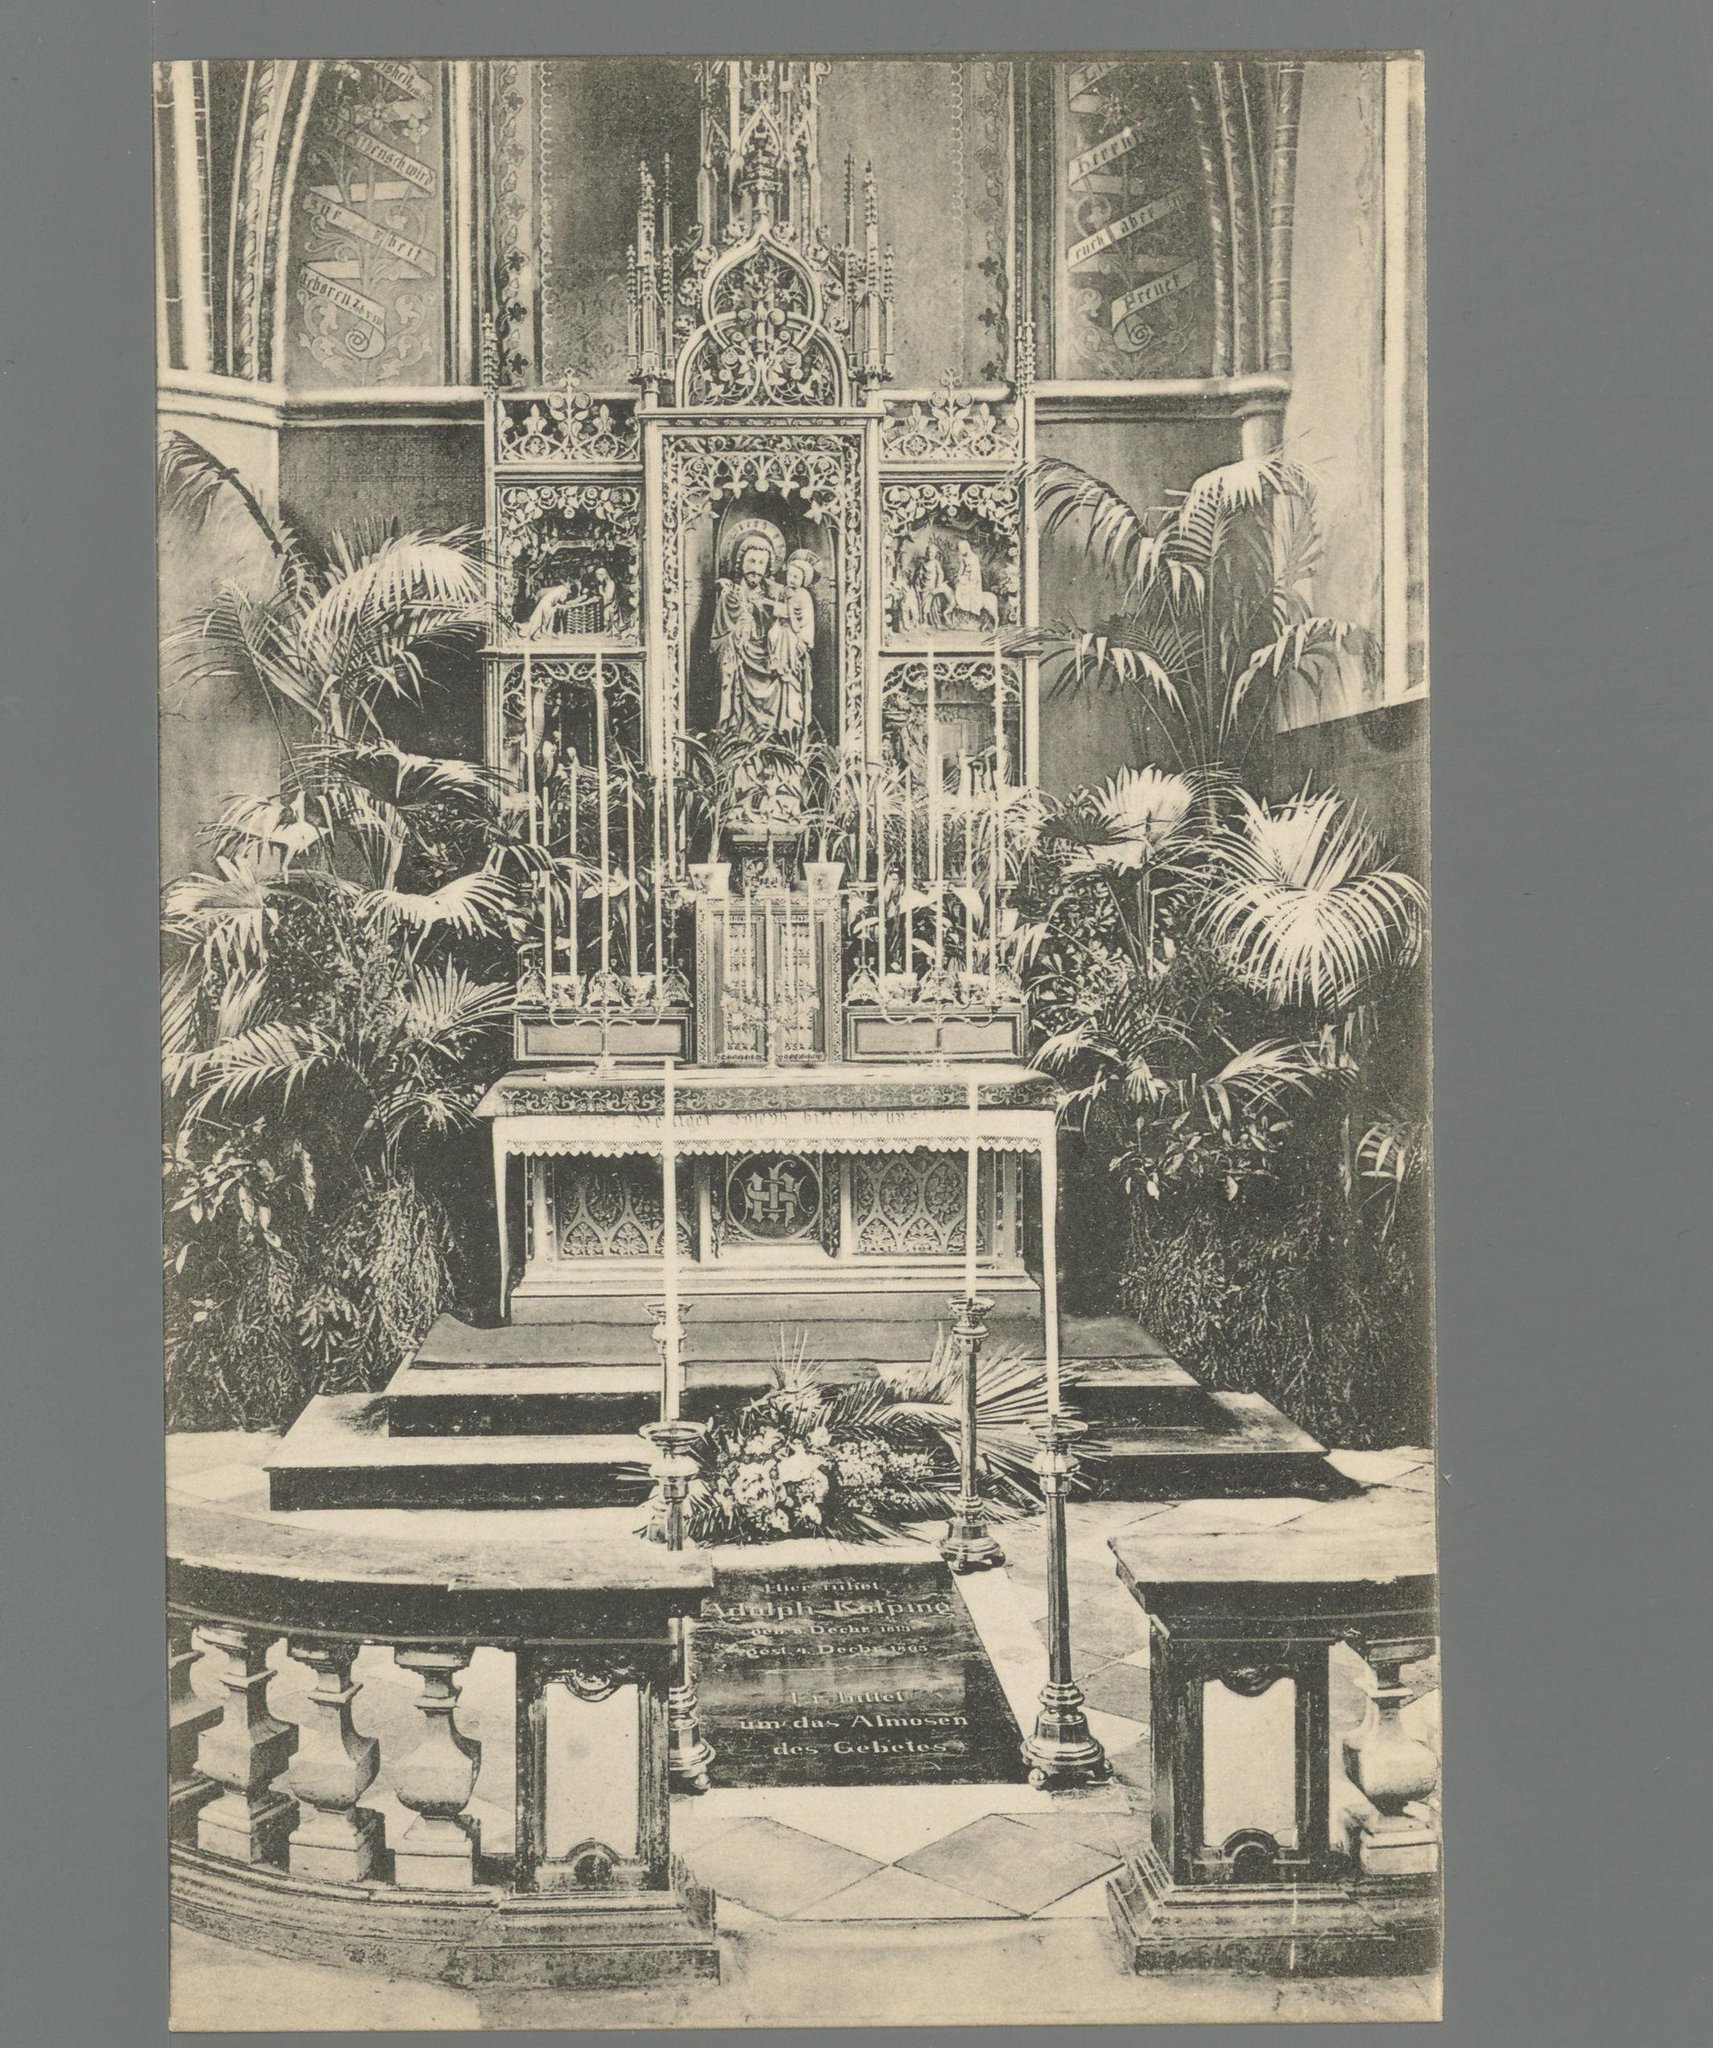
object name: photomechanical print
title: Grabstätte Adolf Kolping in der Minoritenkirche zu Cöln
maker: Anonymous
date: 1913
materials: cardboard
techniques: photograph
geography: cologne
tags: cologne, priest, interior of church, grave-building, monumental tomb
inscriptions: date